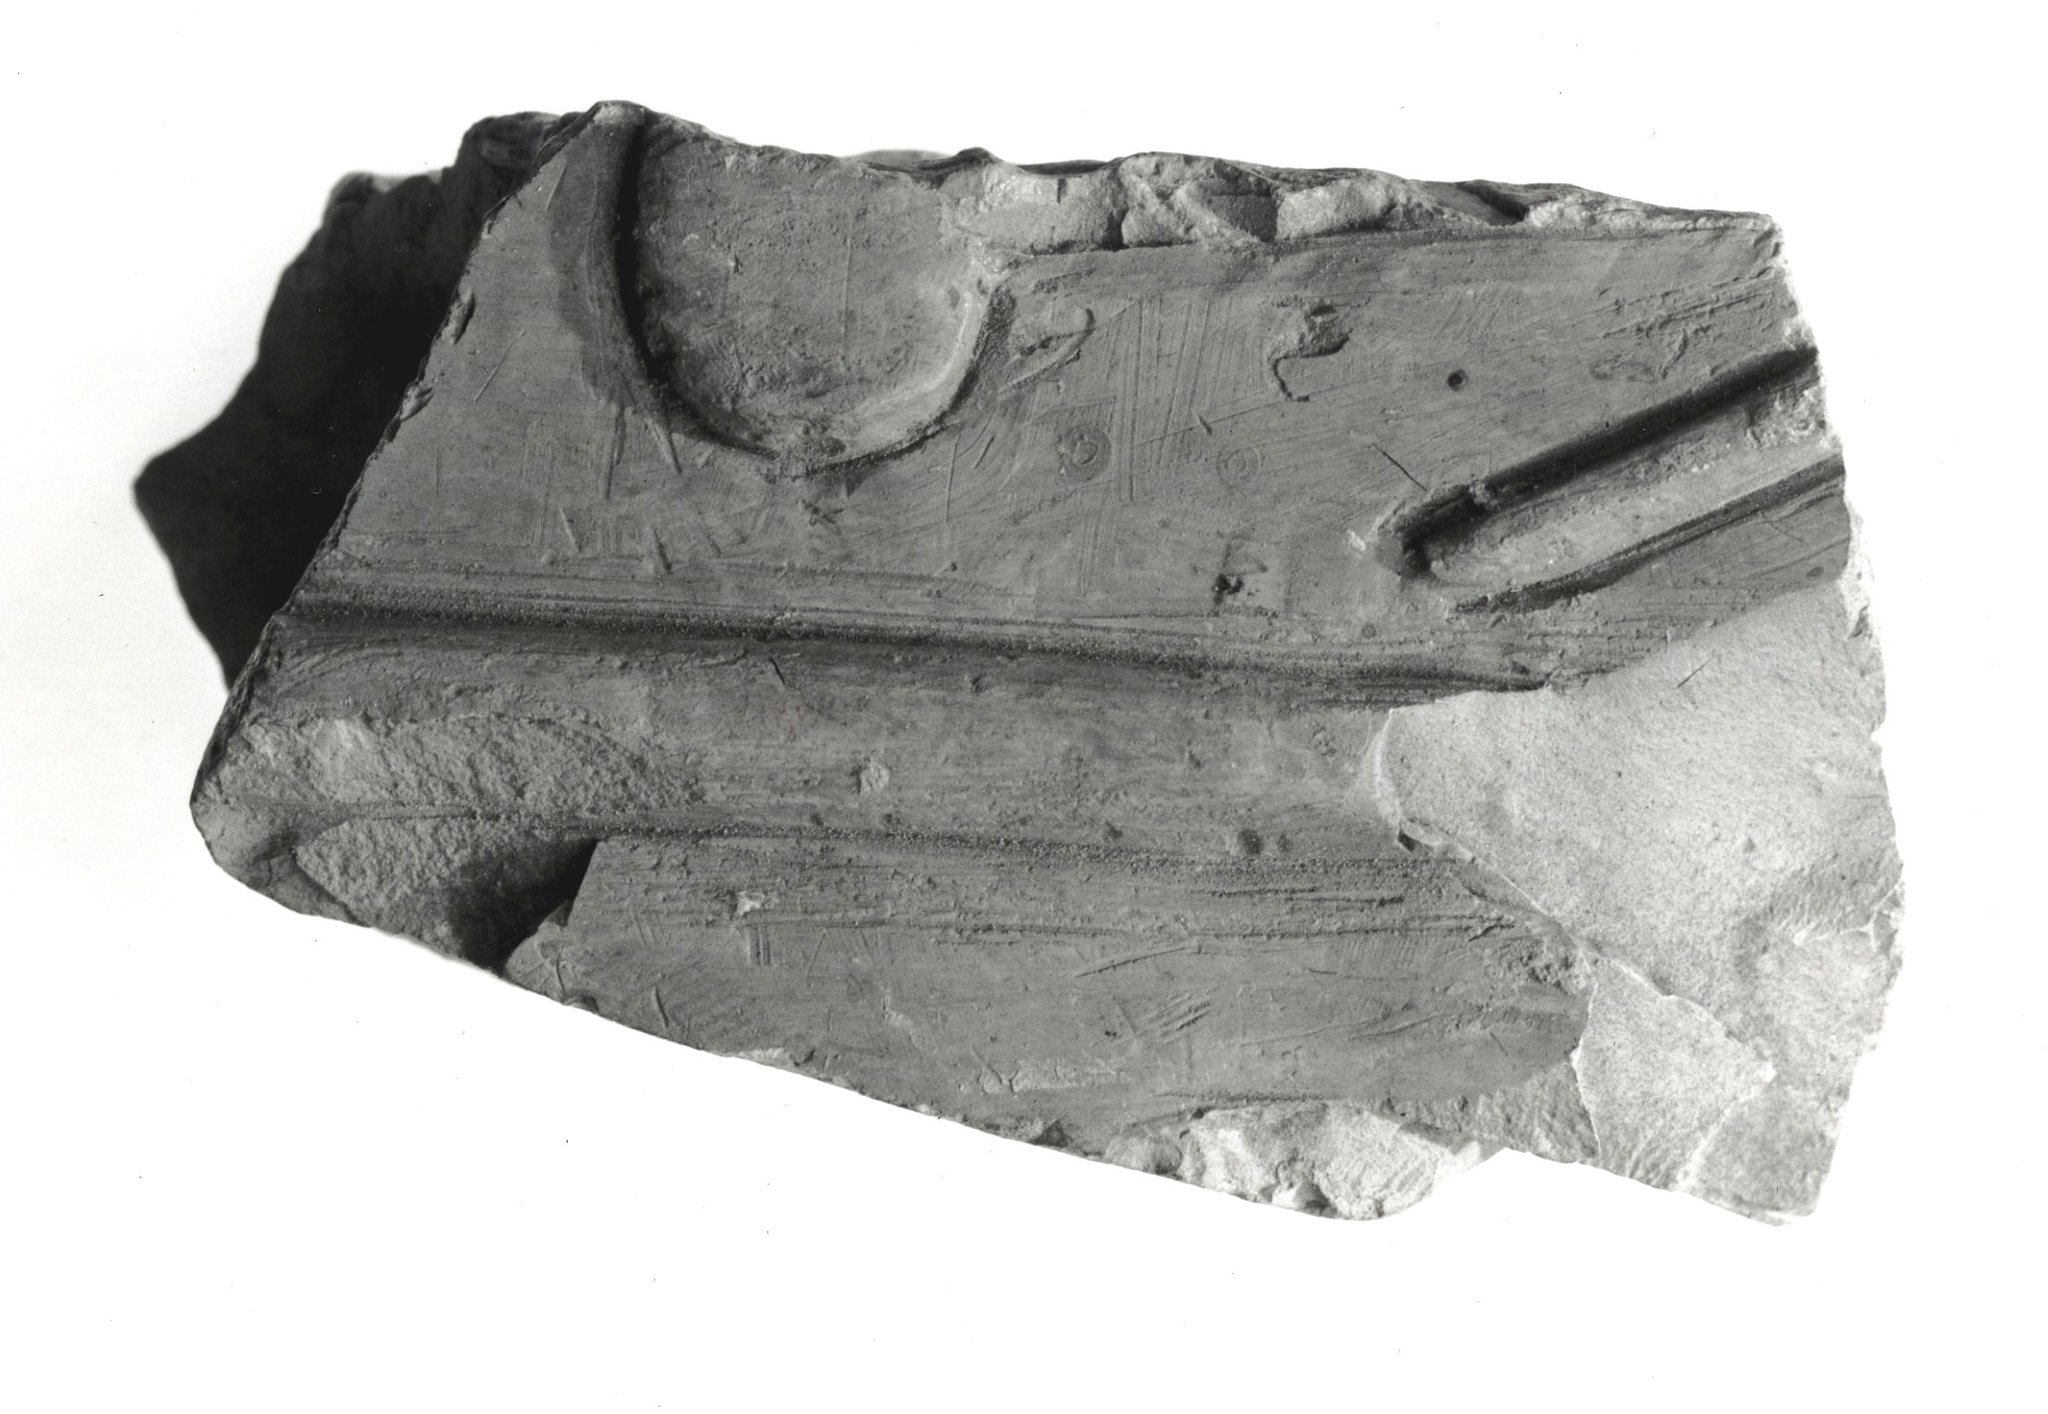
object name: relief, tomb of nespekashuty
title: Raised relief fragment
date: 664-610 BCE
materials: limestone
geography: egypt